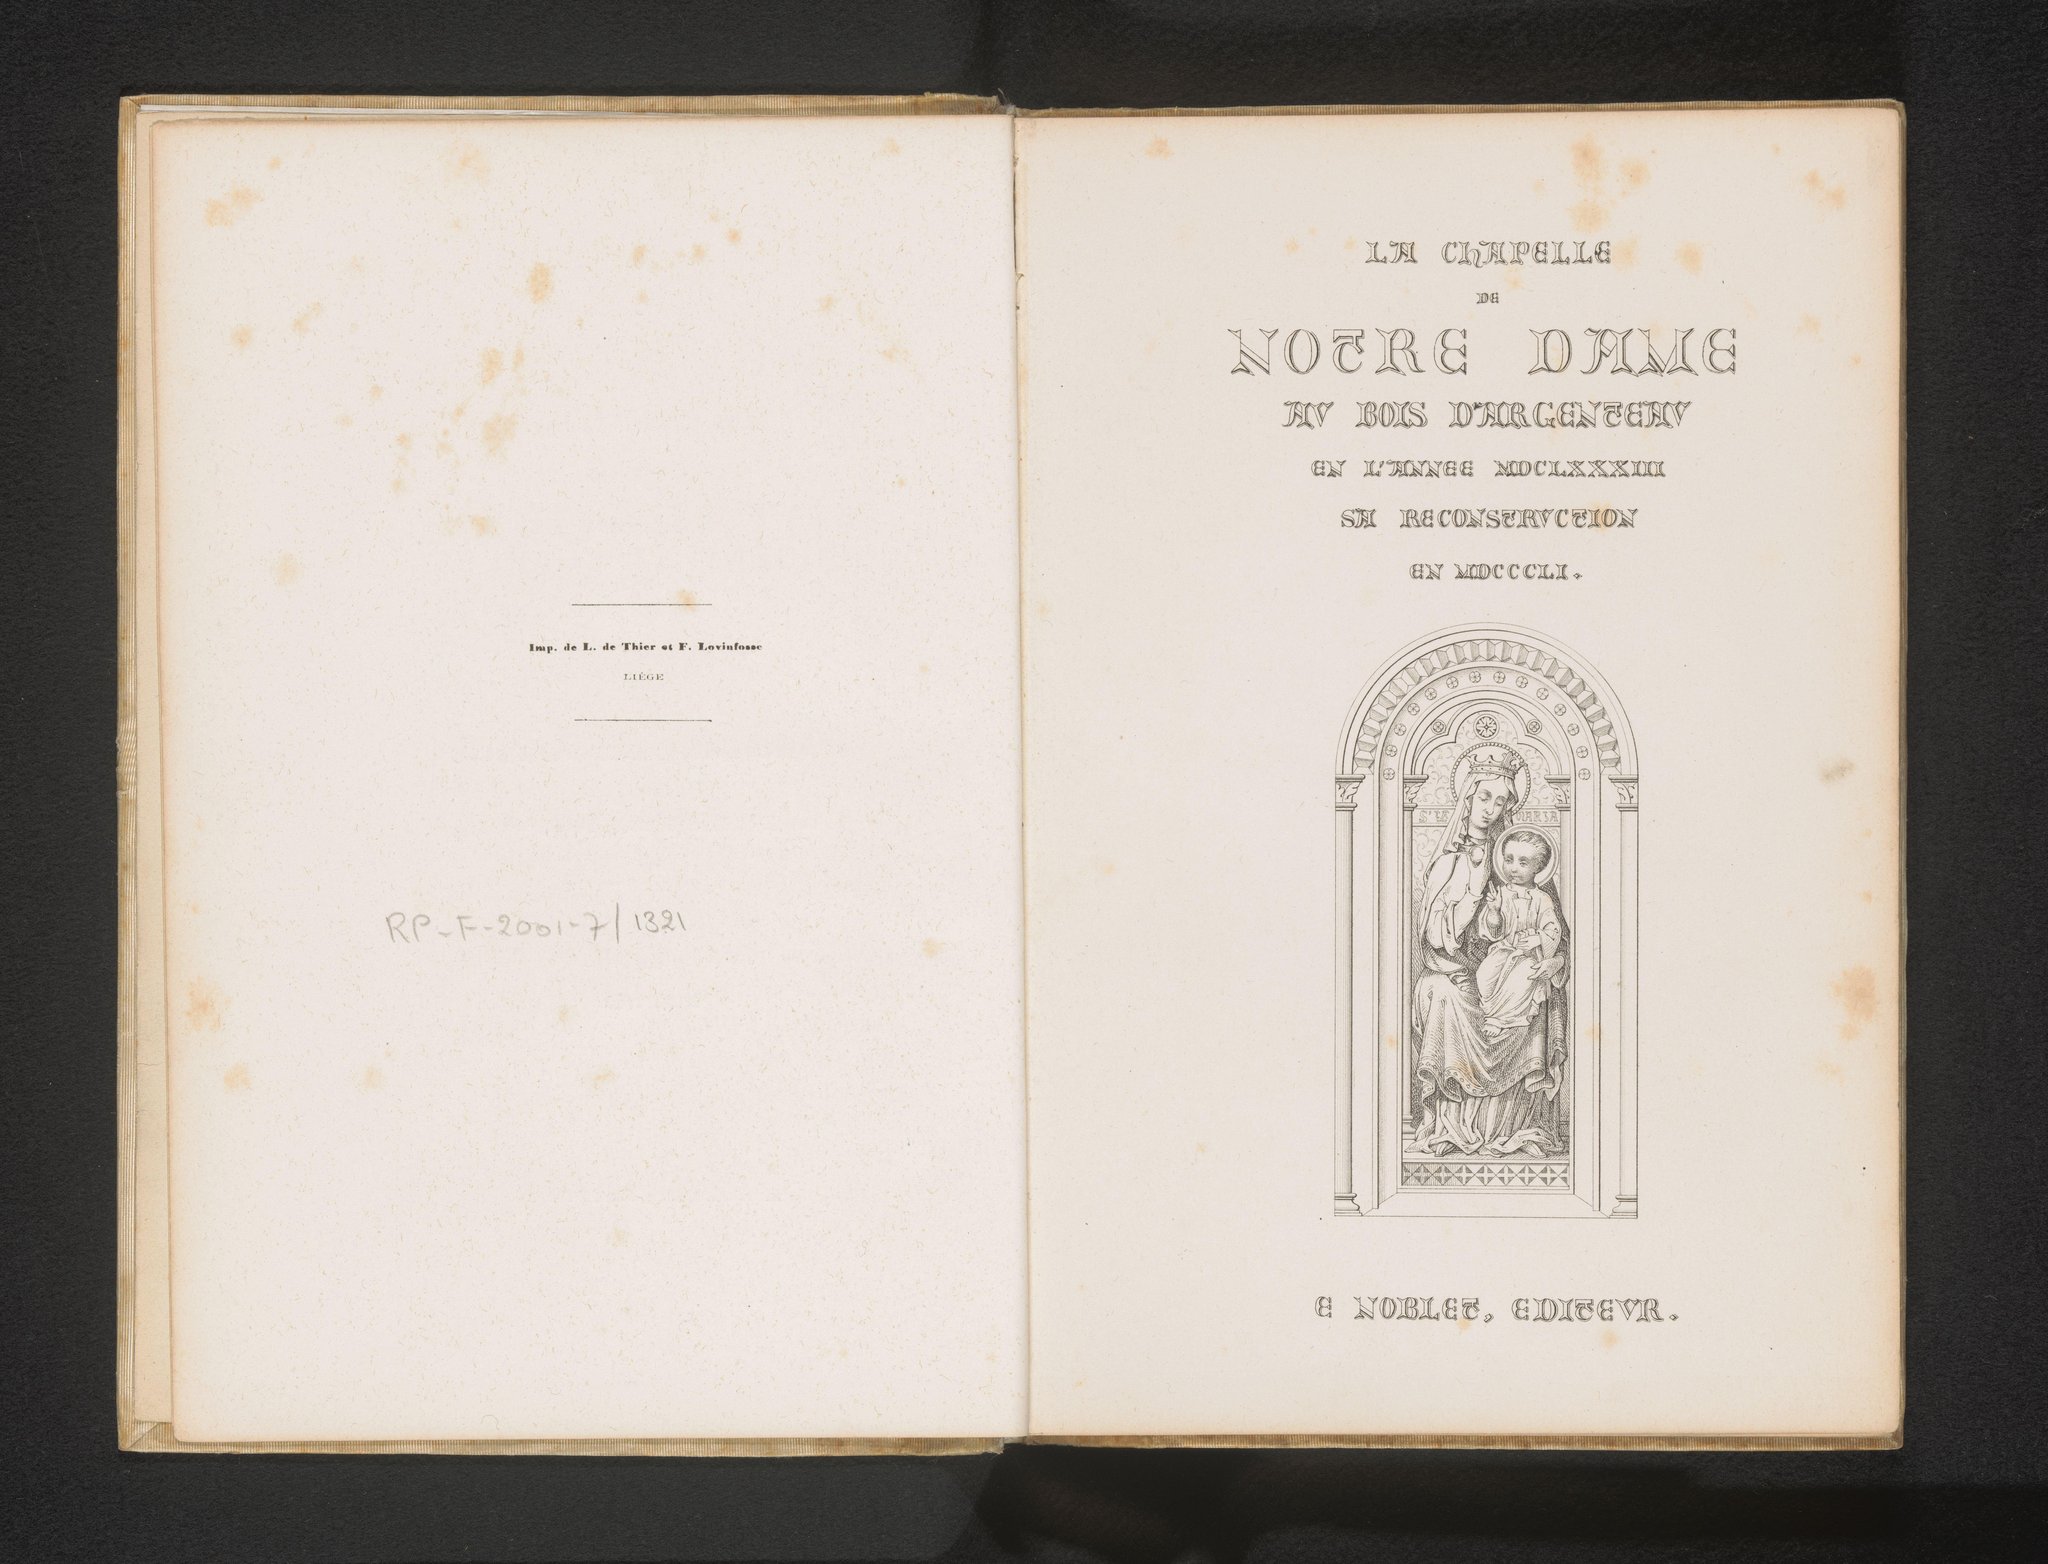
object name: book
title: La chapelle de Notre-Dame au bois d'Argenteau : esquisses généalogique et historique sur l'ancienne seigneurie des terres libres d'Argenteau et Hermalle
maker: e. noblet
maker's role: publisher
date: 1854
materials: cardboard, paper, textile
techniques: printing, salted paper print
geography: liège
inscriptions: annotation: ‘[...]’, annotation: ‘AUG/ 1994’